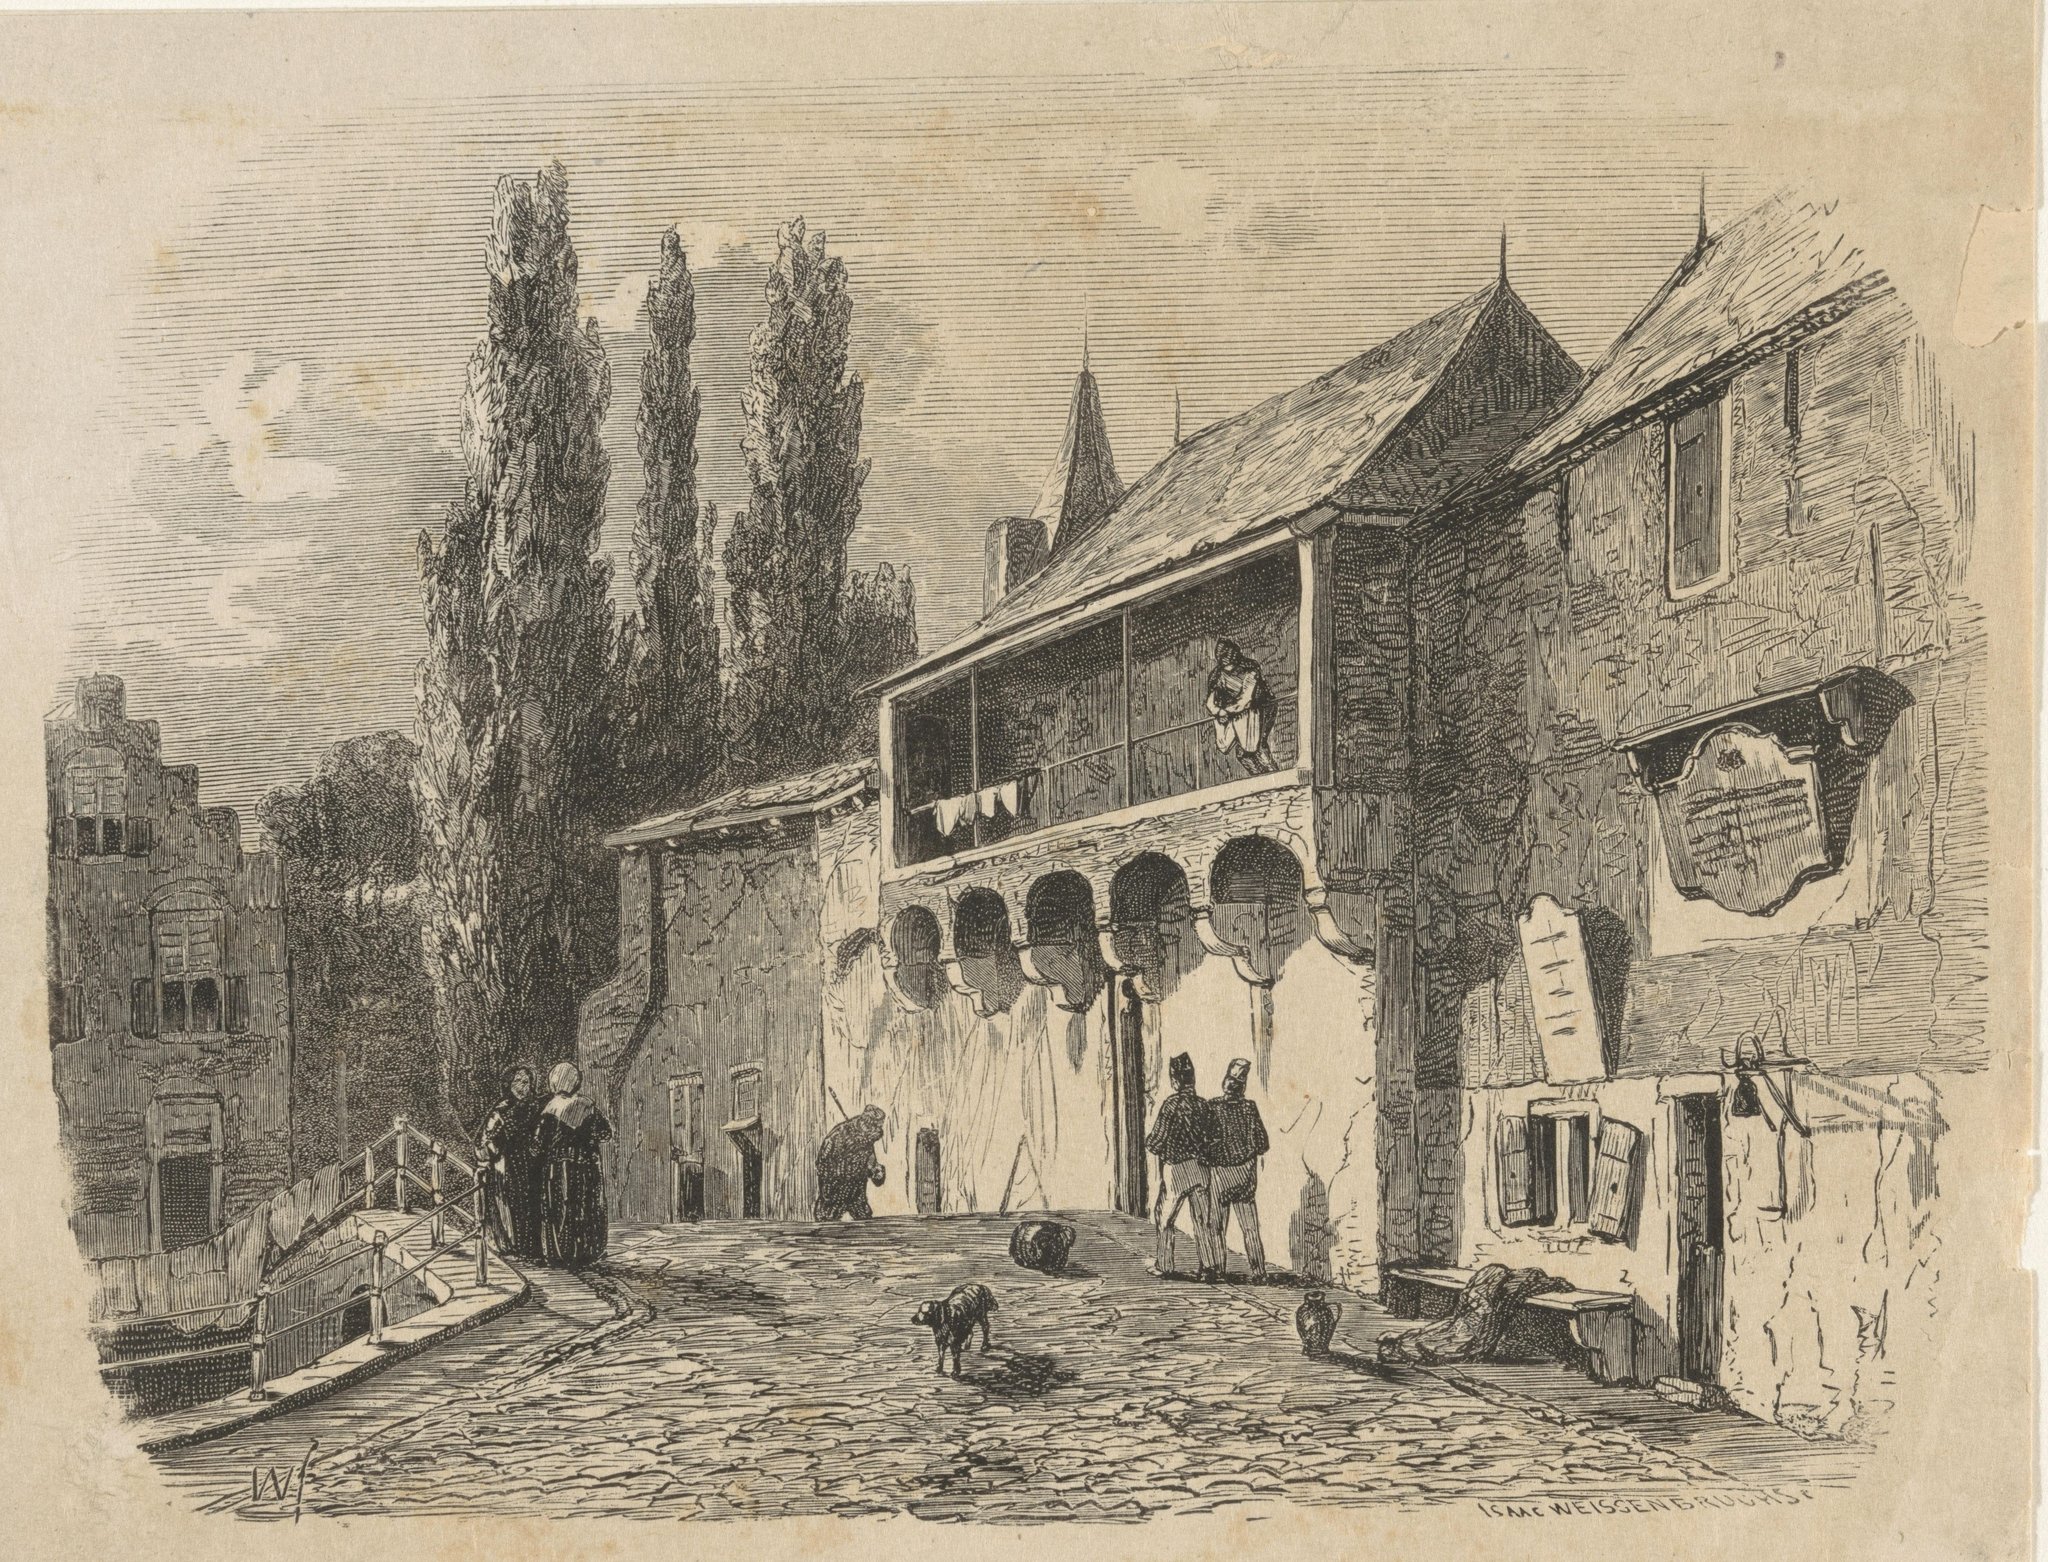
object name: print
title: Gezicht op de Koppelpoort te Amersfoort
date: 1836-1912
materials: paper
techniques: engraving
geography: netherlands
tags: city-gate, street (+ city(-scape) with figures, staffage)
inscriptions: collector's mark: Lugt 2228